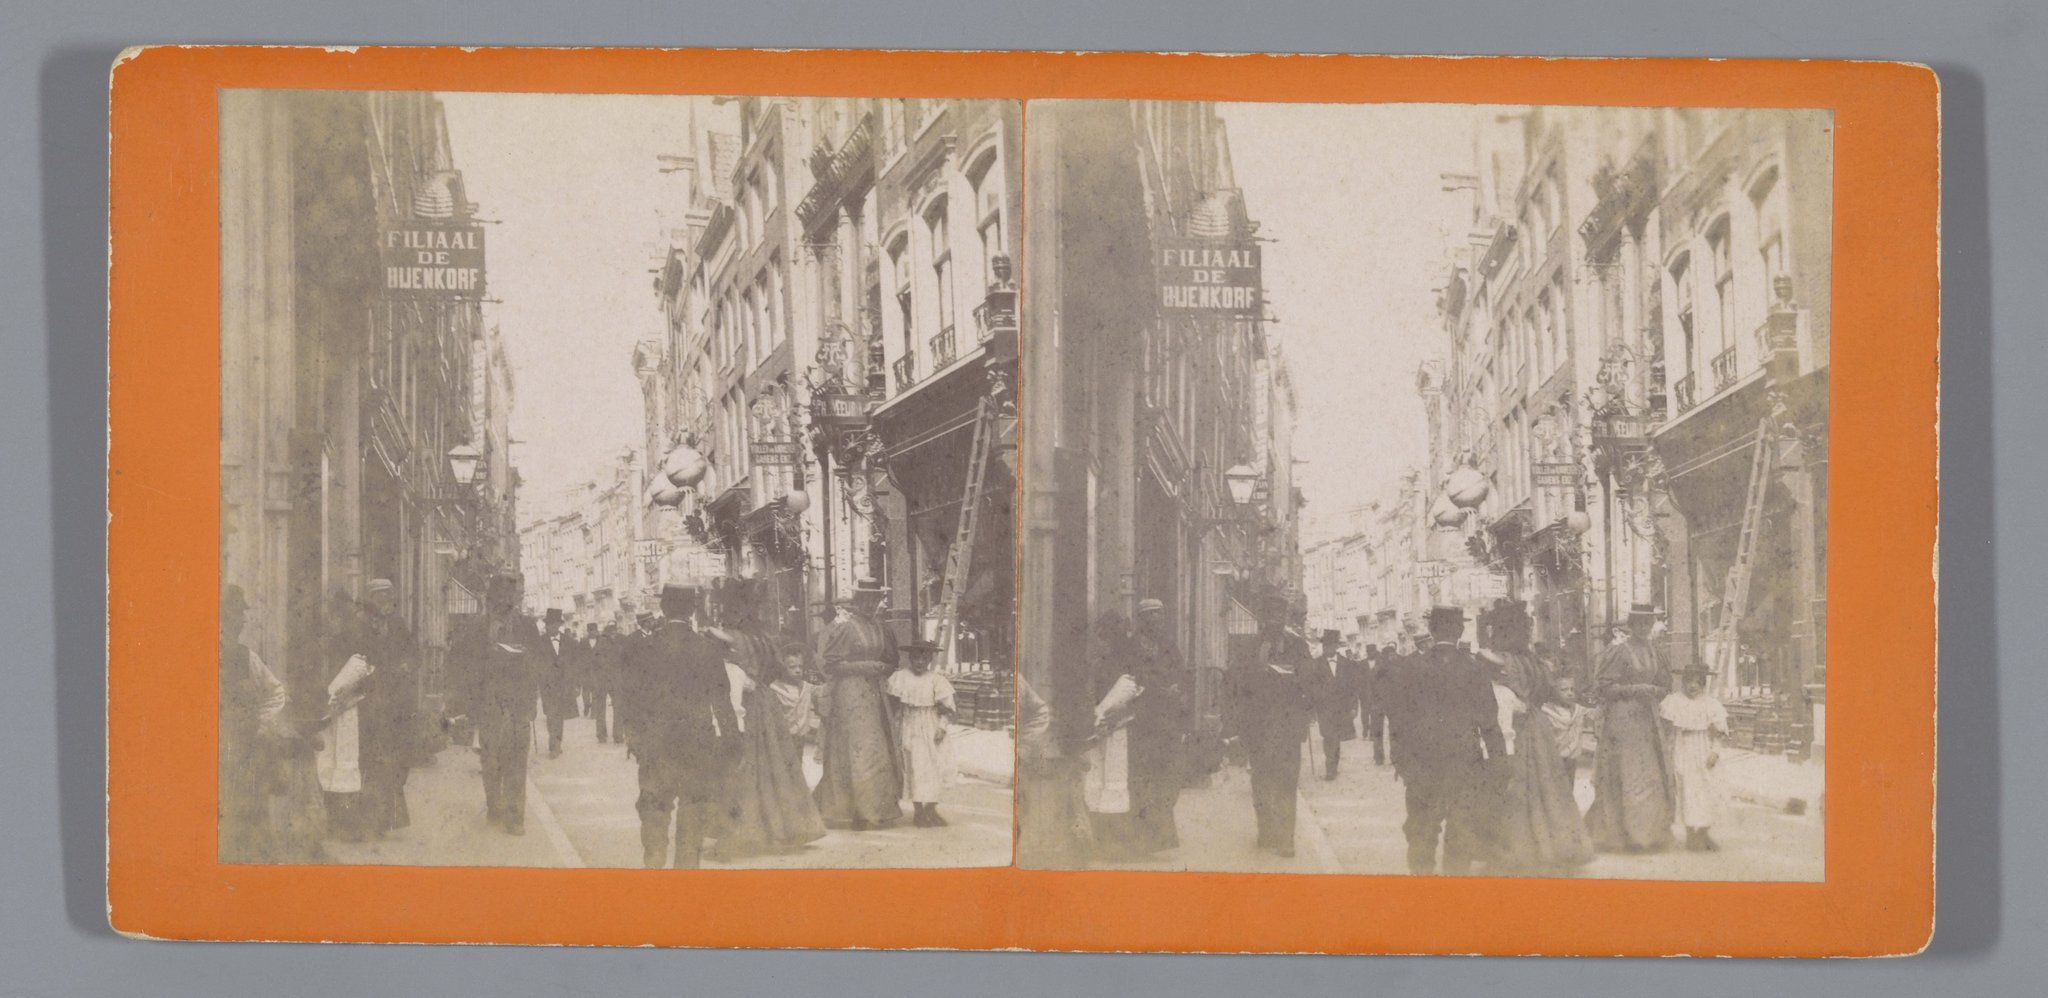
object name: stereograph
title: Winkelend publiek op de Nieuwendijk, Amsterdam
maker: Anonymous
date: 1870-1912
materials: cardboard, paper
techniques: albumen print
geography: amsterdam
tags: street, shop-window, show-window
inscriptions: retailer's mark: ‘Gebr. Douwes/ Ateliers/ Warmoesstraat 73./ Amsterdam’